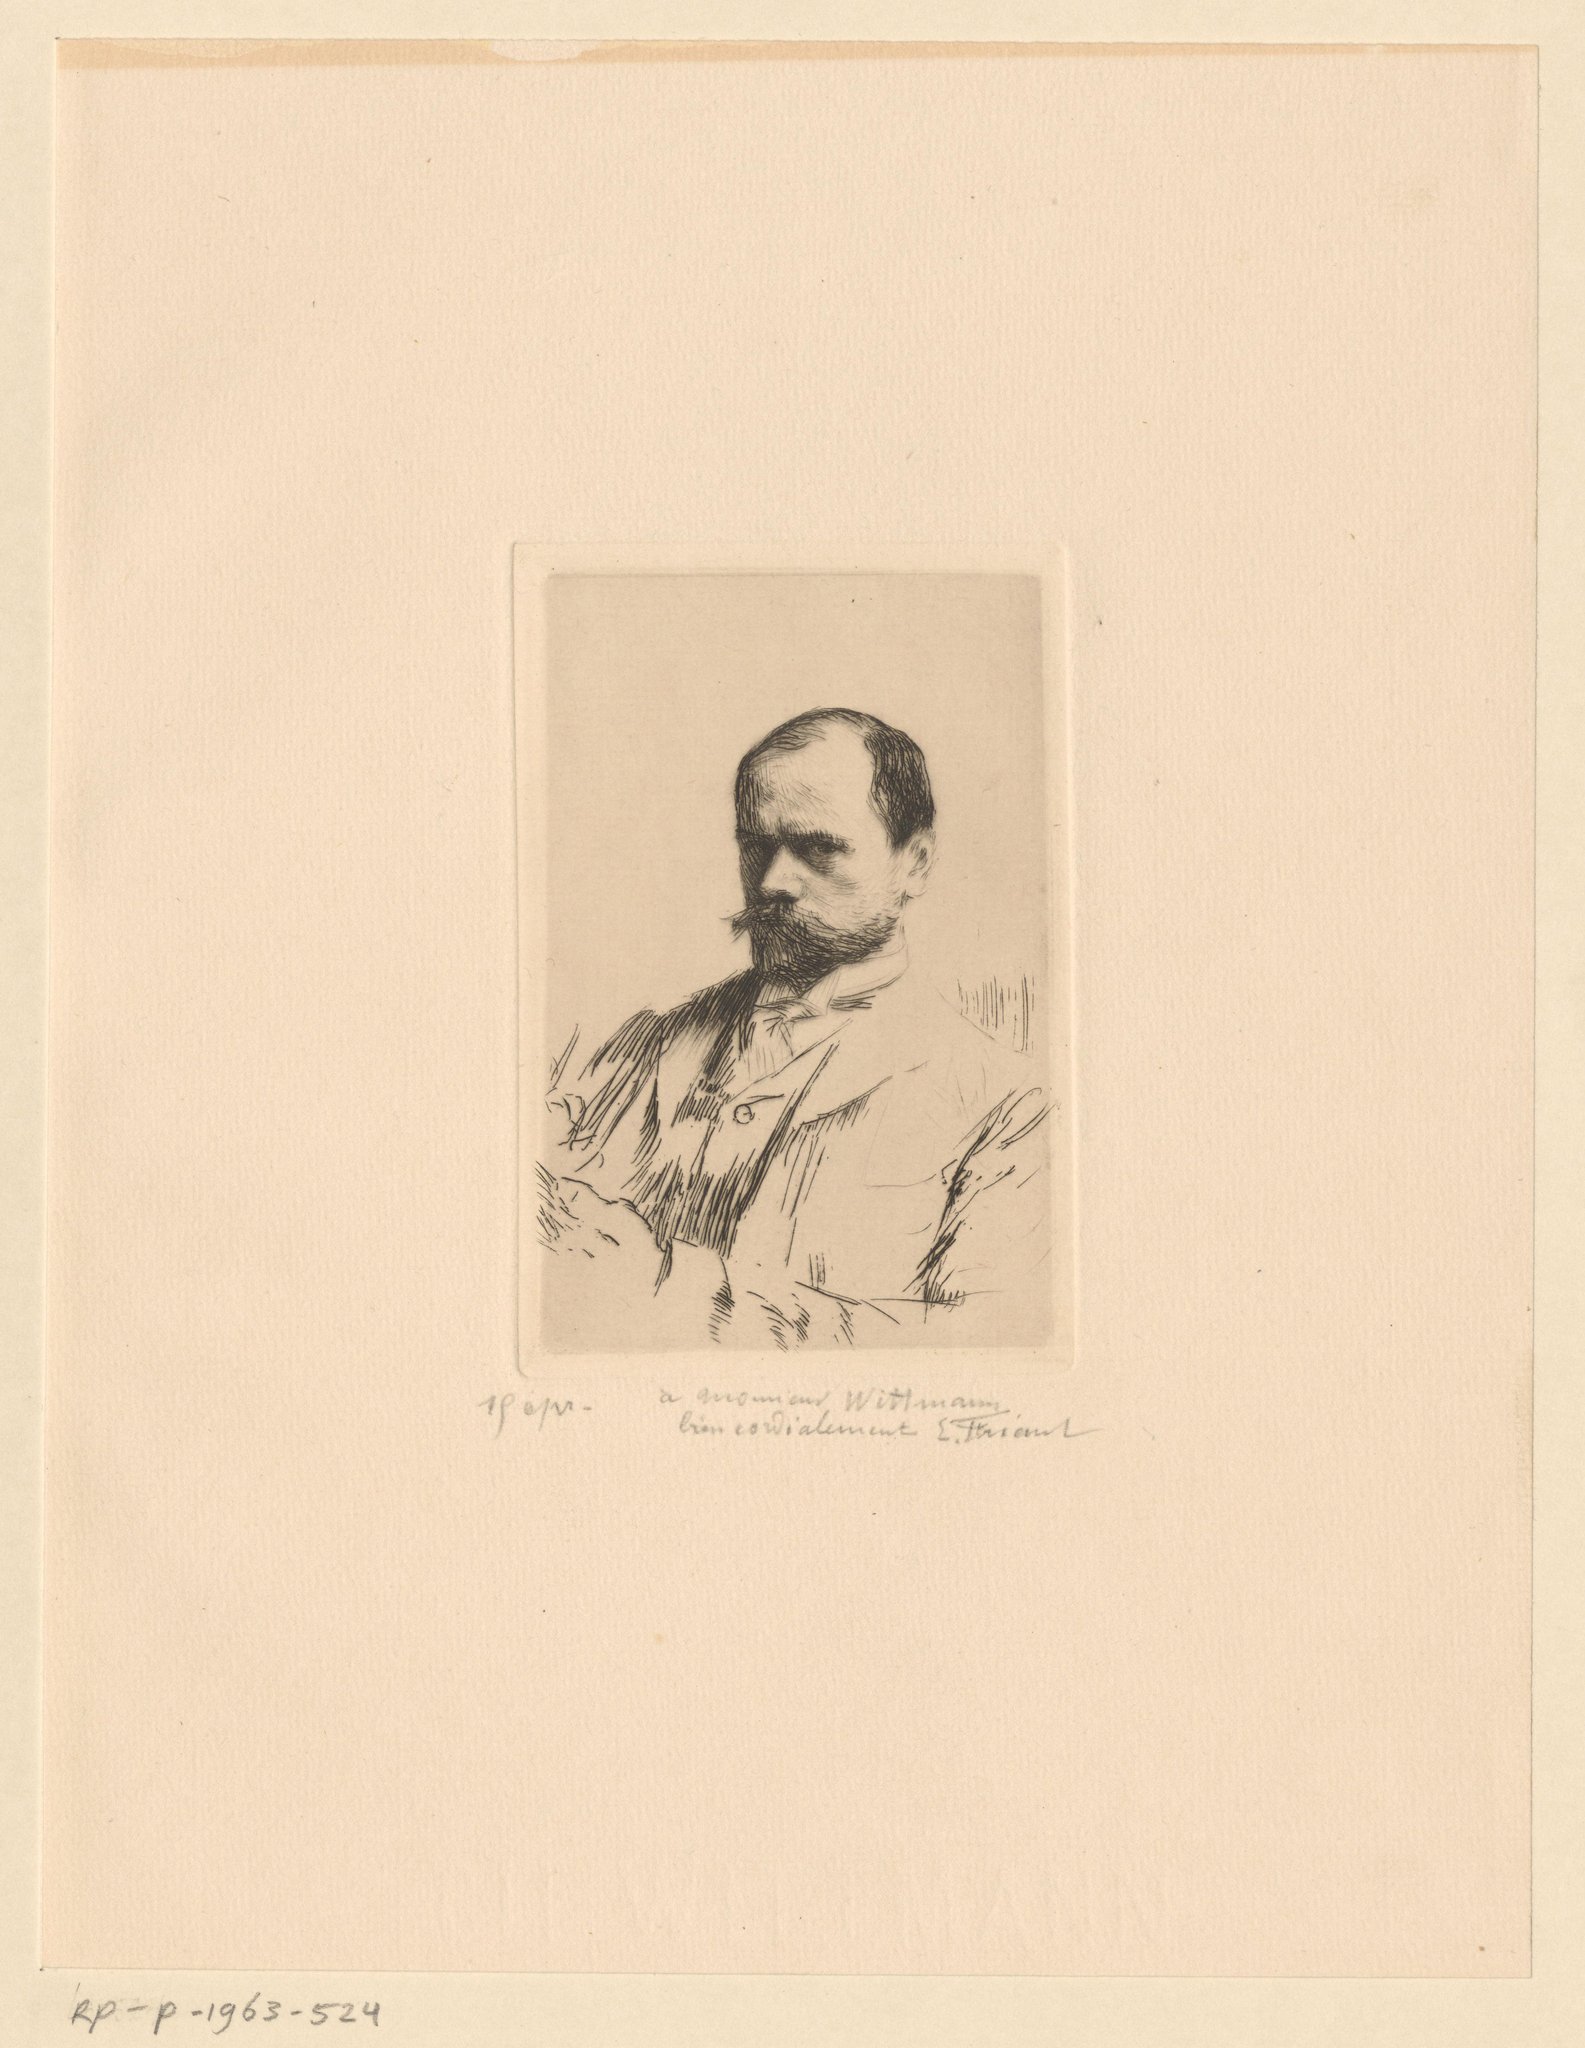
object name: print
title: Zelfportret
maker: emile friant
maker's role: draughtsman, painter, sculptor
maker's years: 1863-1932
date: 1905-1910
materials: paper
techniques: drypoint, etching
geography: france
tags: paris, draughtsman, sculptor, emile friant, historical persons, portrait, self-portrait of artist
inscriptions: collector's mark: Lugt 2228, inscription: ‘19 apr. à monsieur Wittmann,/ bien cordialement E. Friant’